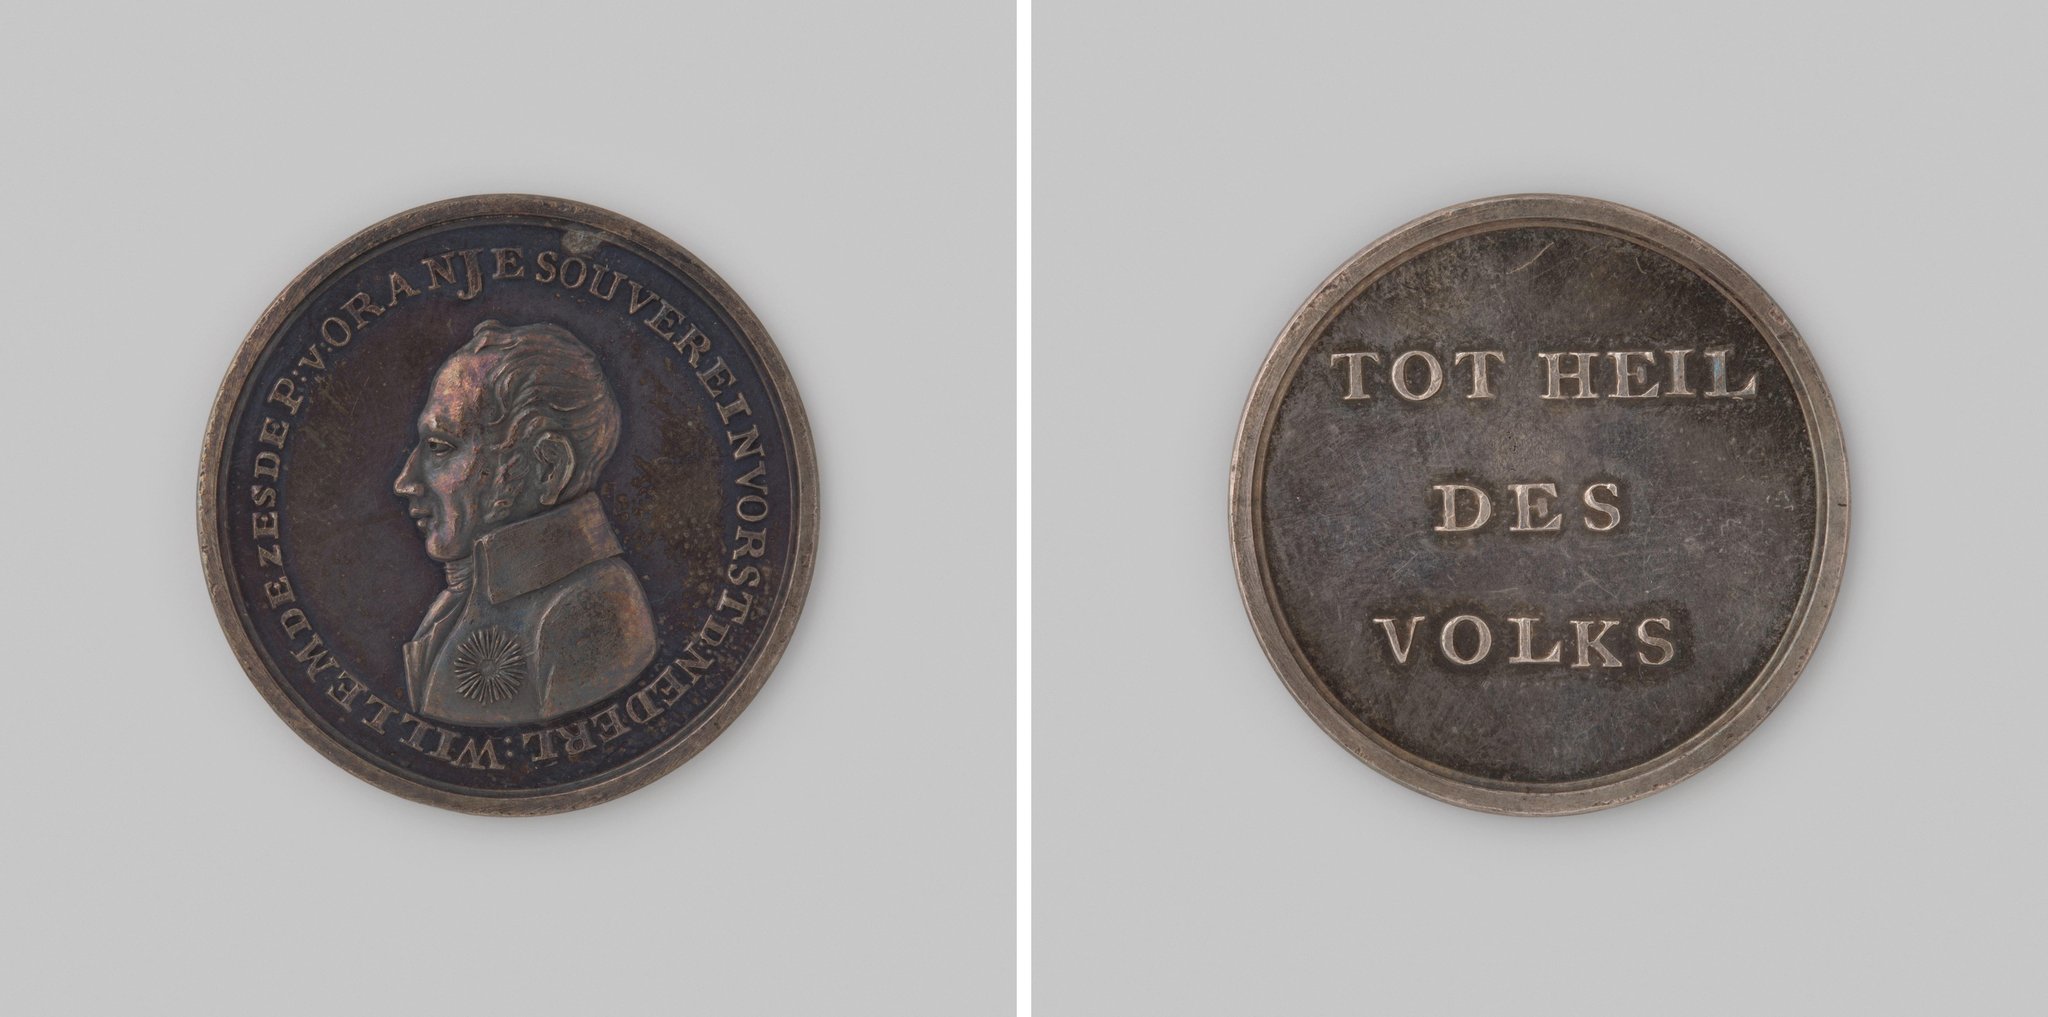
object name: history medal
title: Willem Frederik van Oranje Souverein Vorst der Nederlanden 1813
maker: hendrik lageman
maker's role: draughtsman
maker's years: 1765-1816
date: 1813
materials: silver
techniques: striking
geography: amsterdam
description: Zilveren penning, op de voorzijde het borstbeeld naar links van Willem Frederik met omschrift, op de keerzijde drie regels tekst.